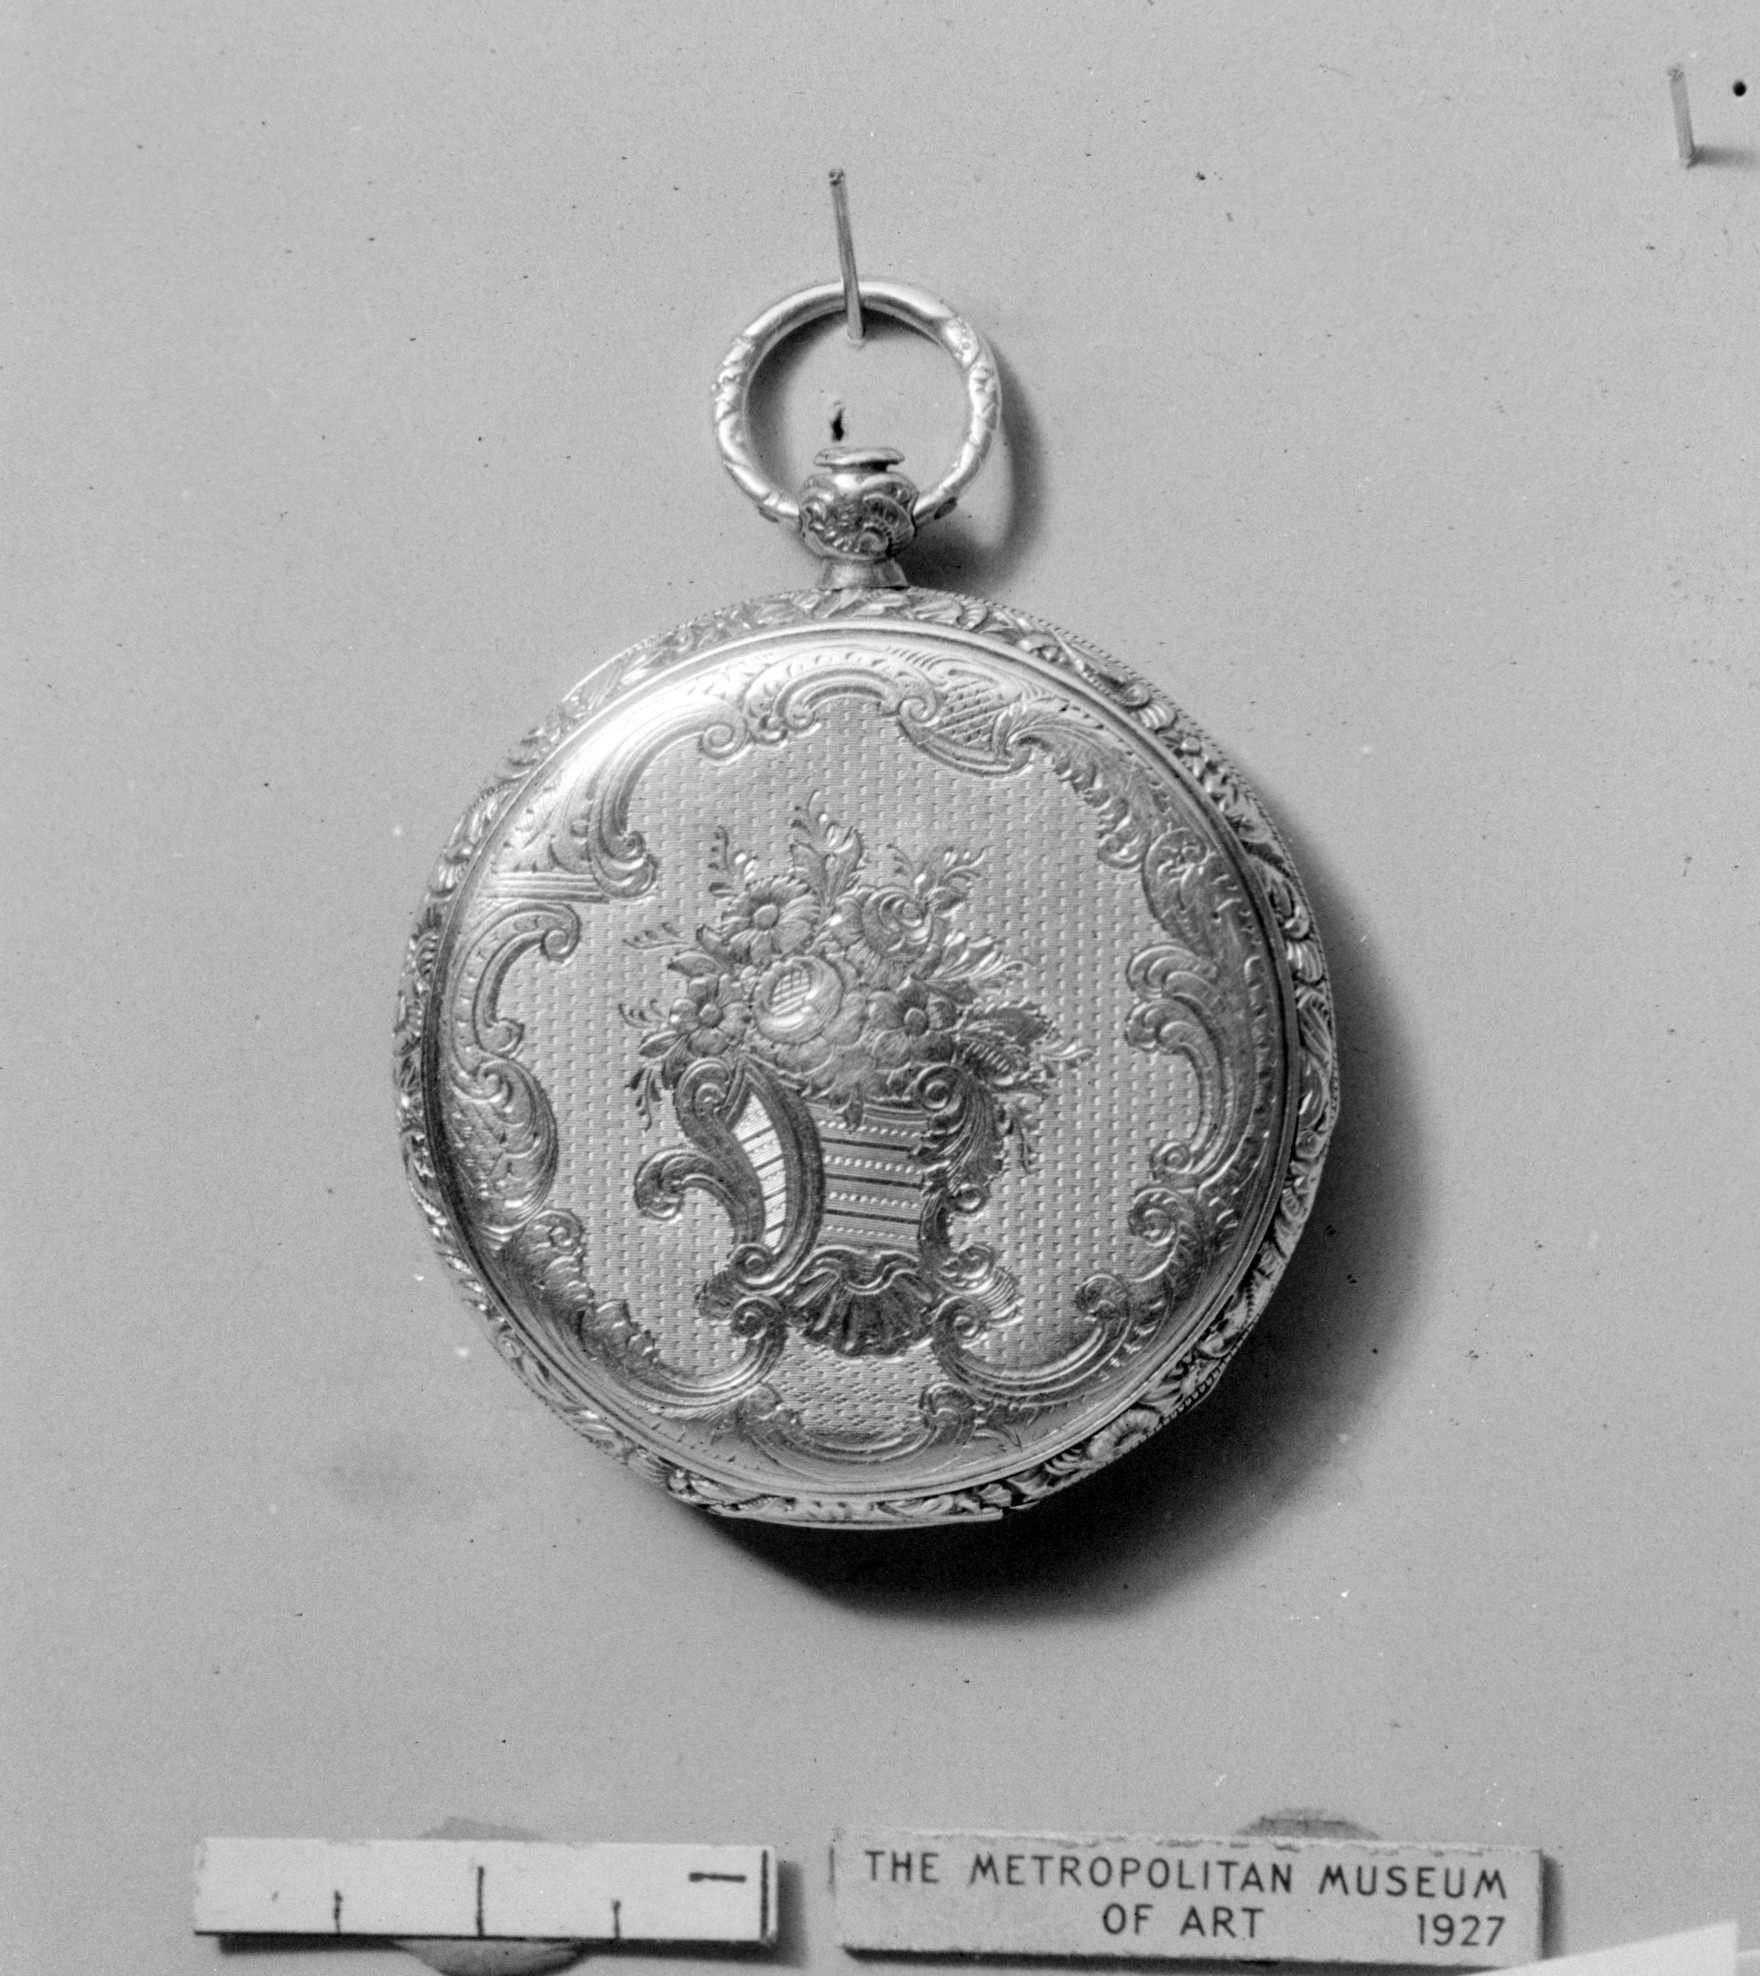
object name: watch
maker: firm of piguet & cie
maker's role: maker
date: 1830-1840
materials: gold, silver, steel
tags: flowers